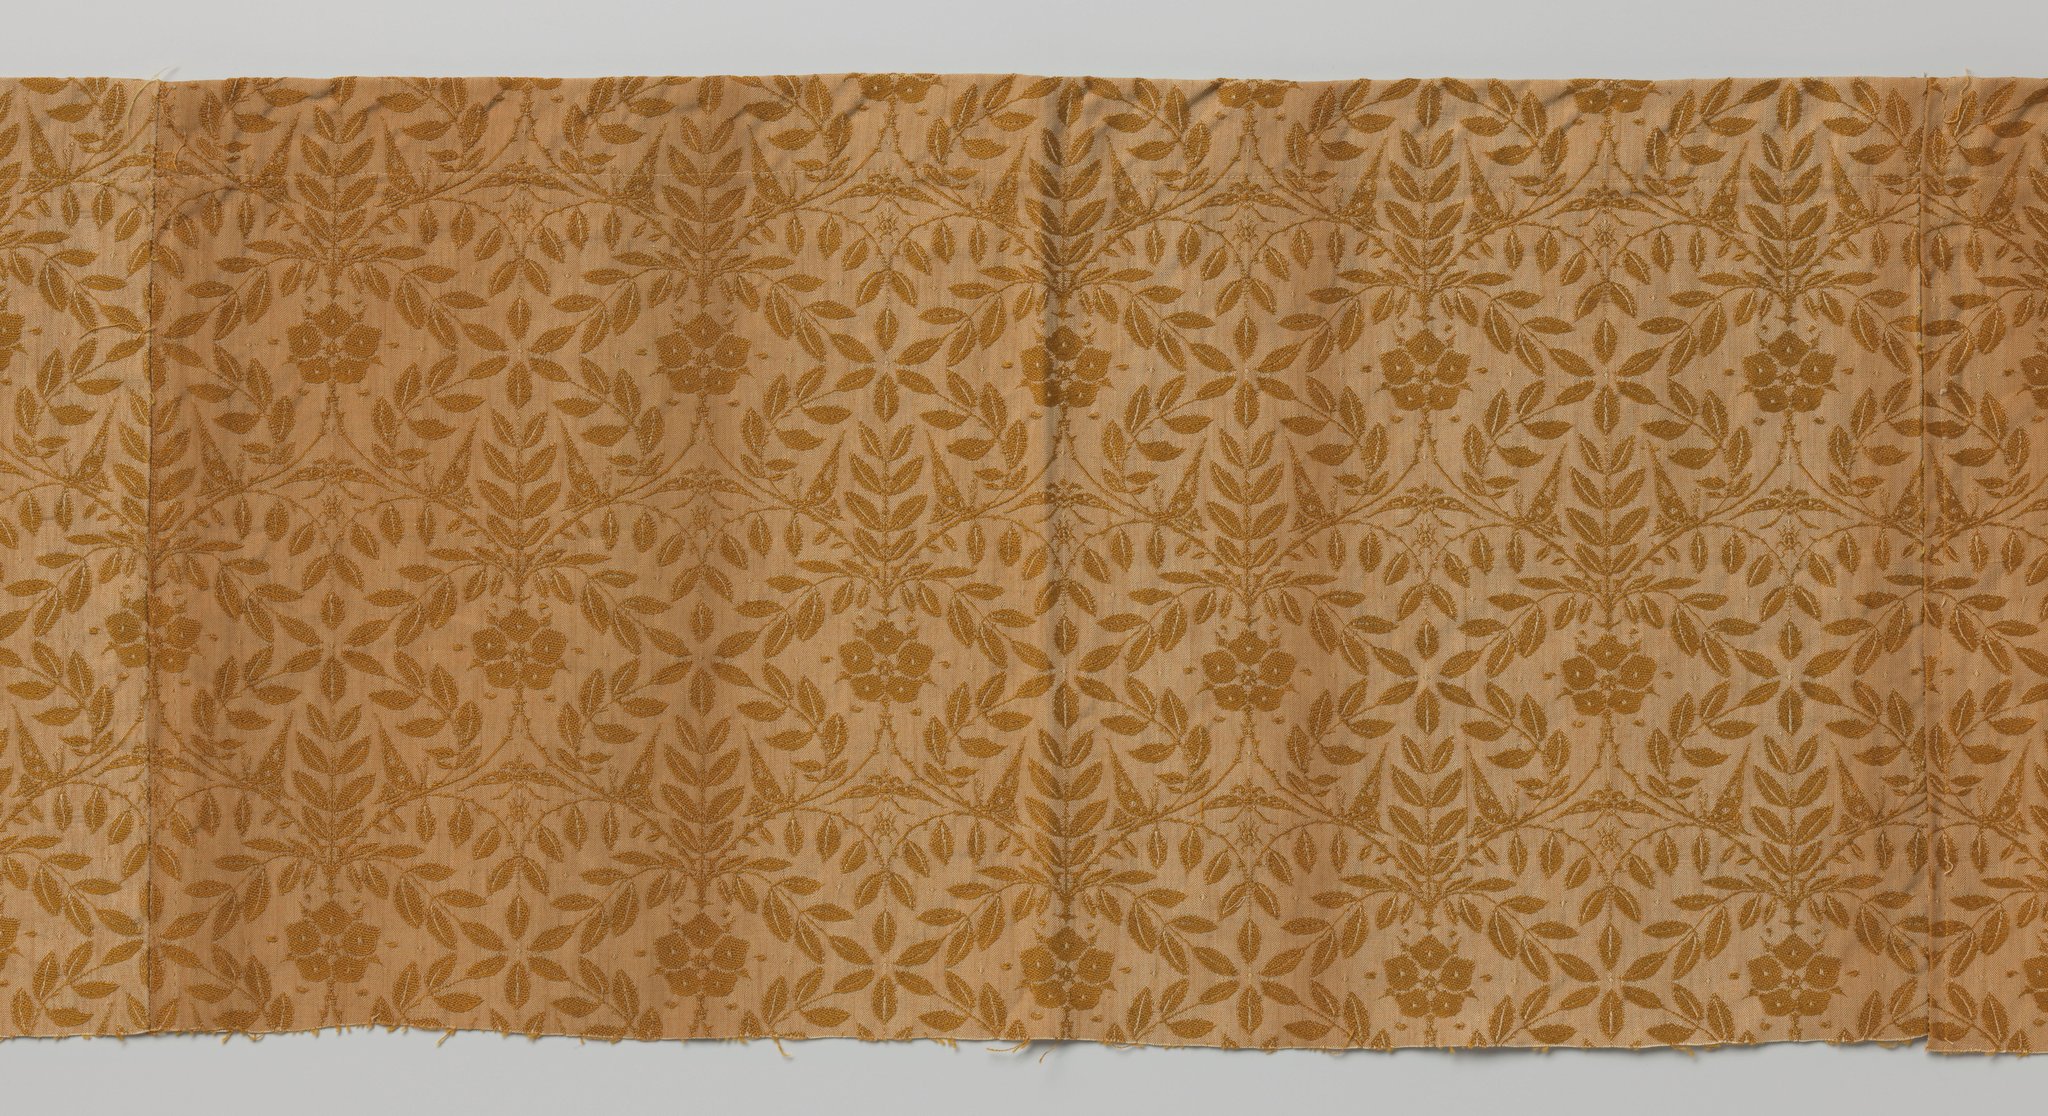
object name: upholstered wall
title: Fragment van wandbespanning of gordijnstof met patroon van bloemen, bladeren en insecten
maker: theo nieuwenhuis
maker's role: designer, draughtsman, print maker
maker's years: 1866-1951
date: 1909-1924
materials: cotton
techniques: jacquard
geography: helmond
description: Fragment gordijnstof van vier aan elkaar genaaide stukken met patroon van gestileerde bloemen en bladertakken in spitsovalen, waarin onderaan een vlinder en kever in een ruitpatroon van takken. Beige ketting met okergele inslag.